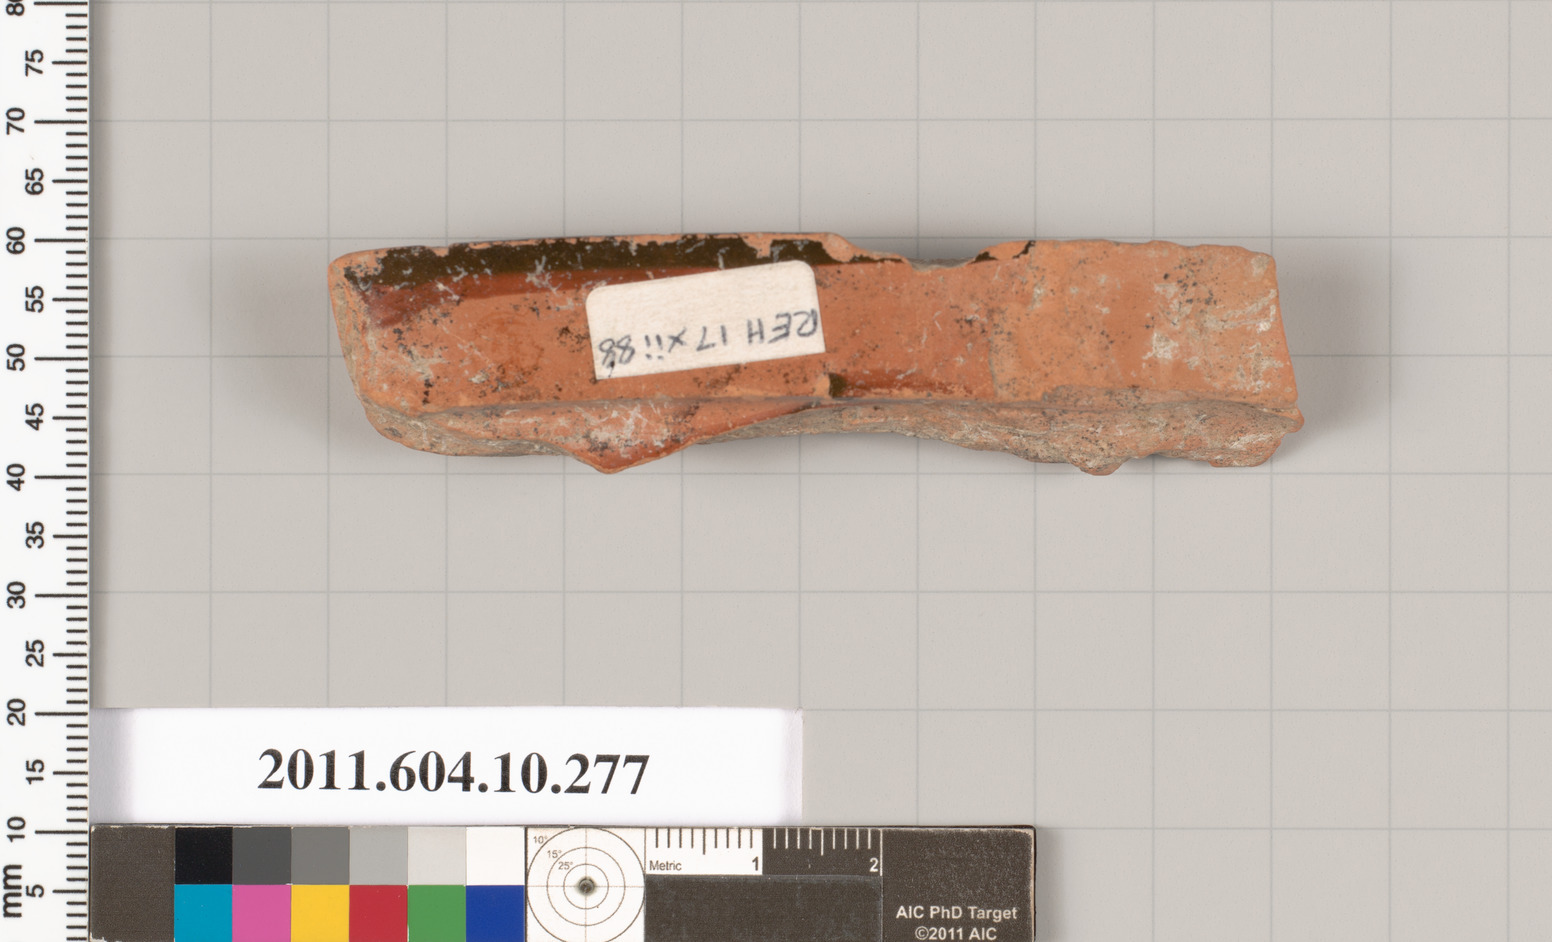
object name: undetermined shape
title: Terracotta fragment of an undetermined shape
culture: etruscan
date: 567-535 BCE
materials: terracotta